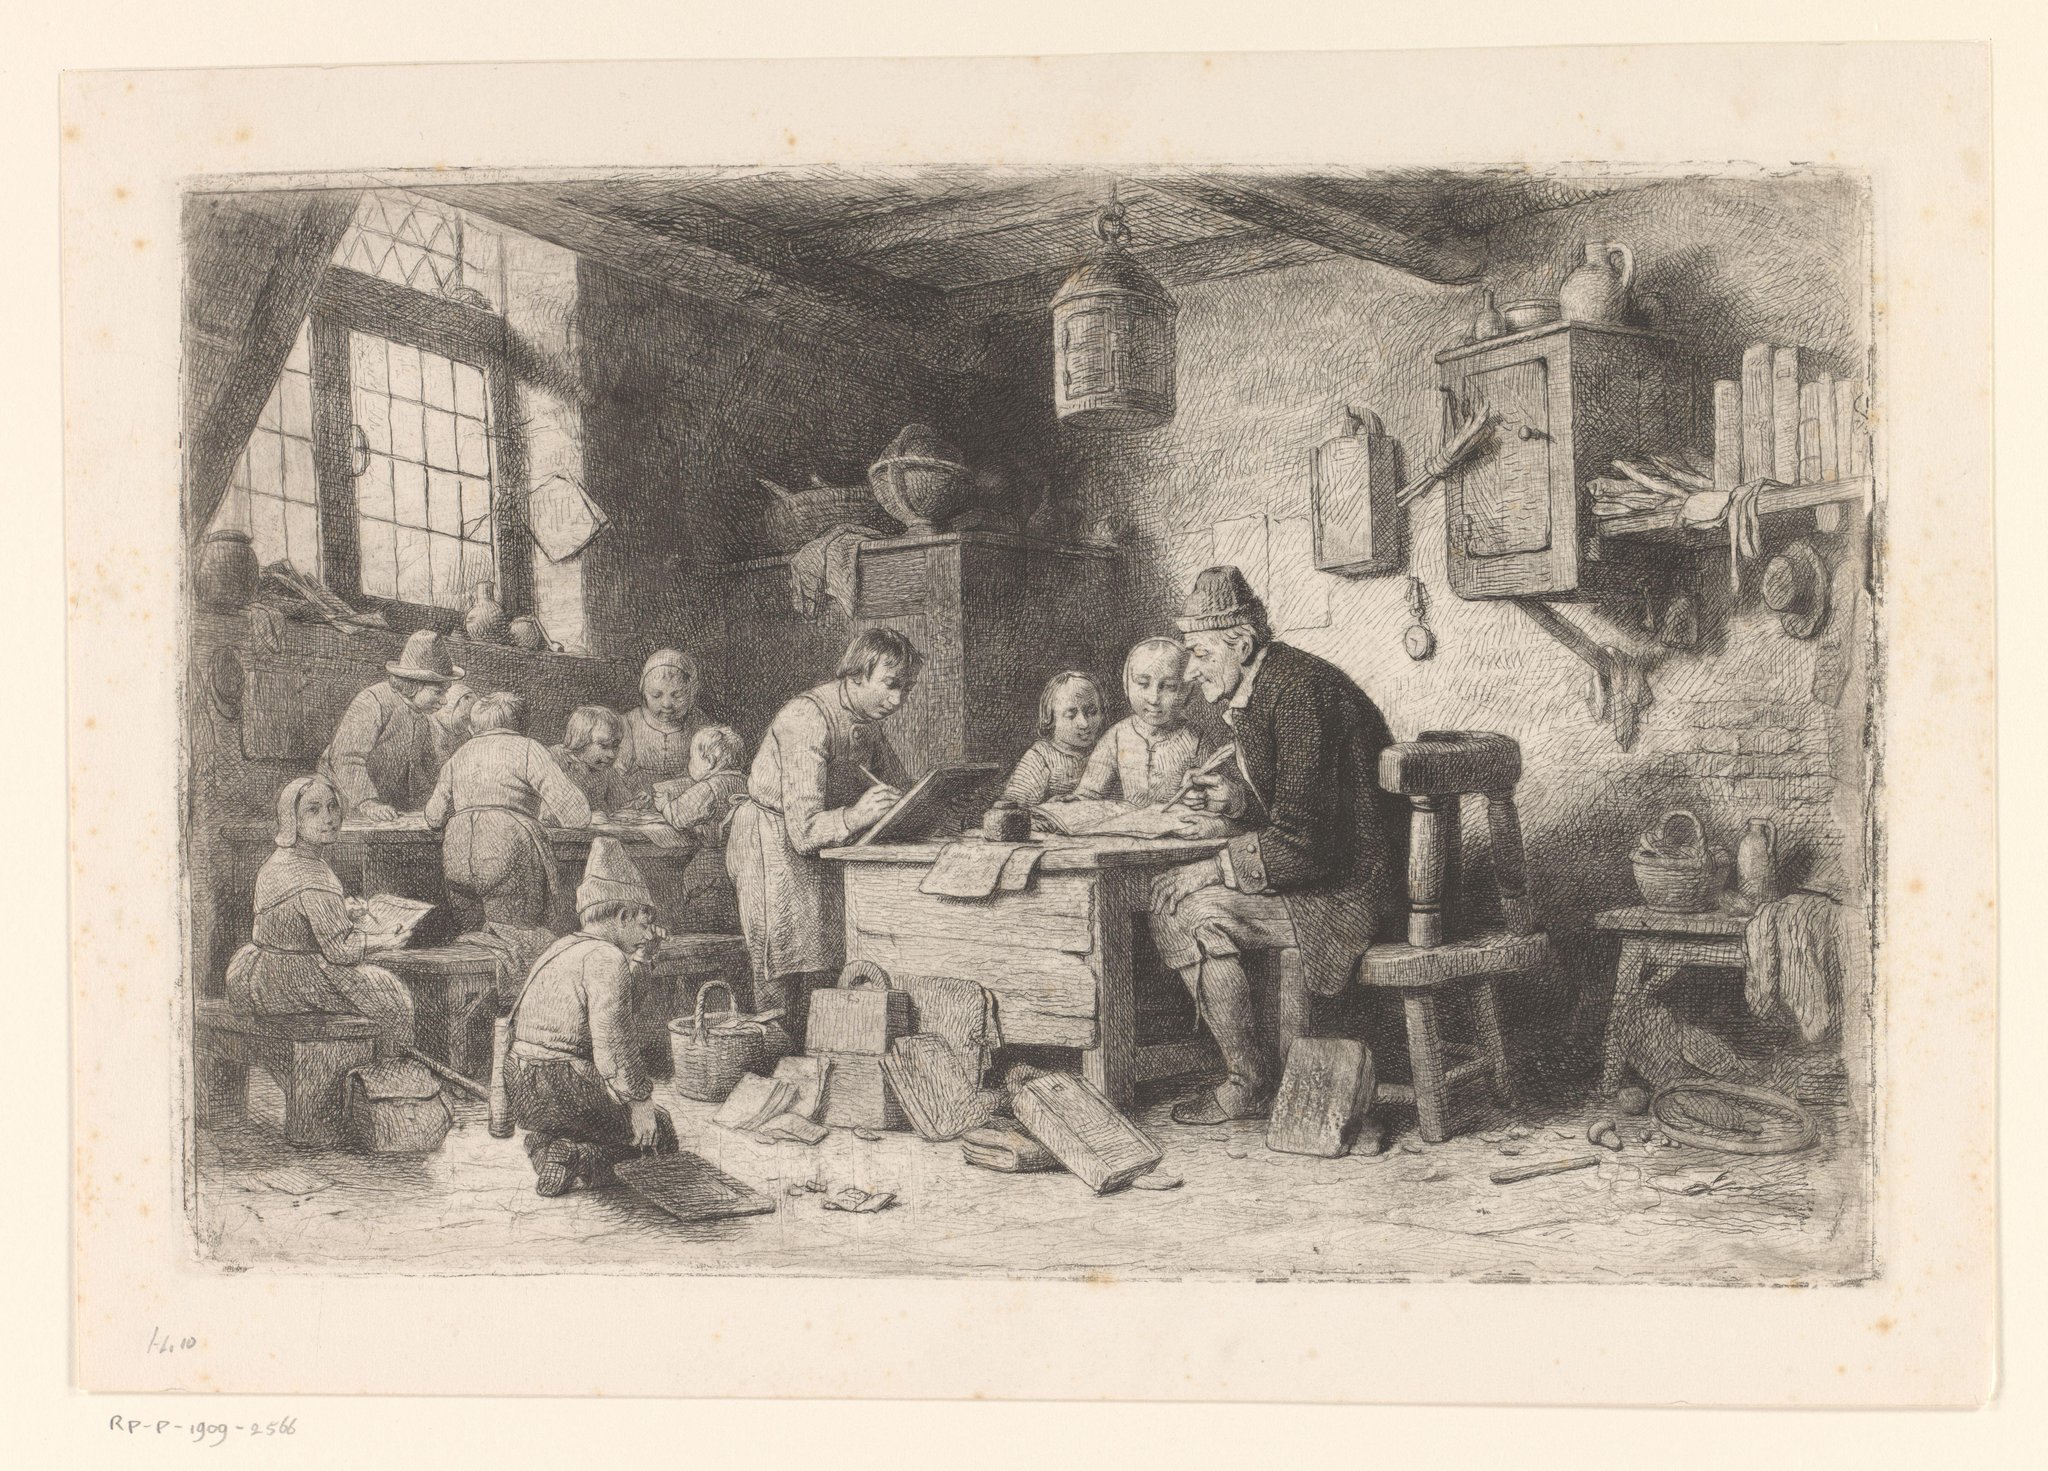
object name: print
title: Les van de schoolmeester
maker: ferdinand de braekeleer (i)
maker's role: draughtsman, print maker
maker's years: 1792-1883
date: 1802-1883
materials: paper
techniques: etching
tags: teacher and pupil, education, elementary school; class, form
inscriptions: collector's mark: Lugt 2228, collector's mark: Lugt 1485